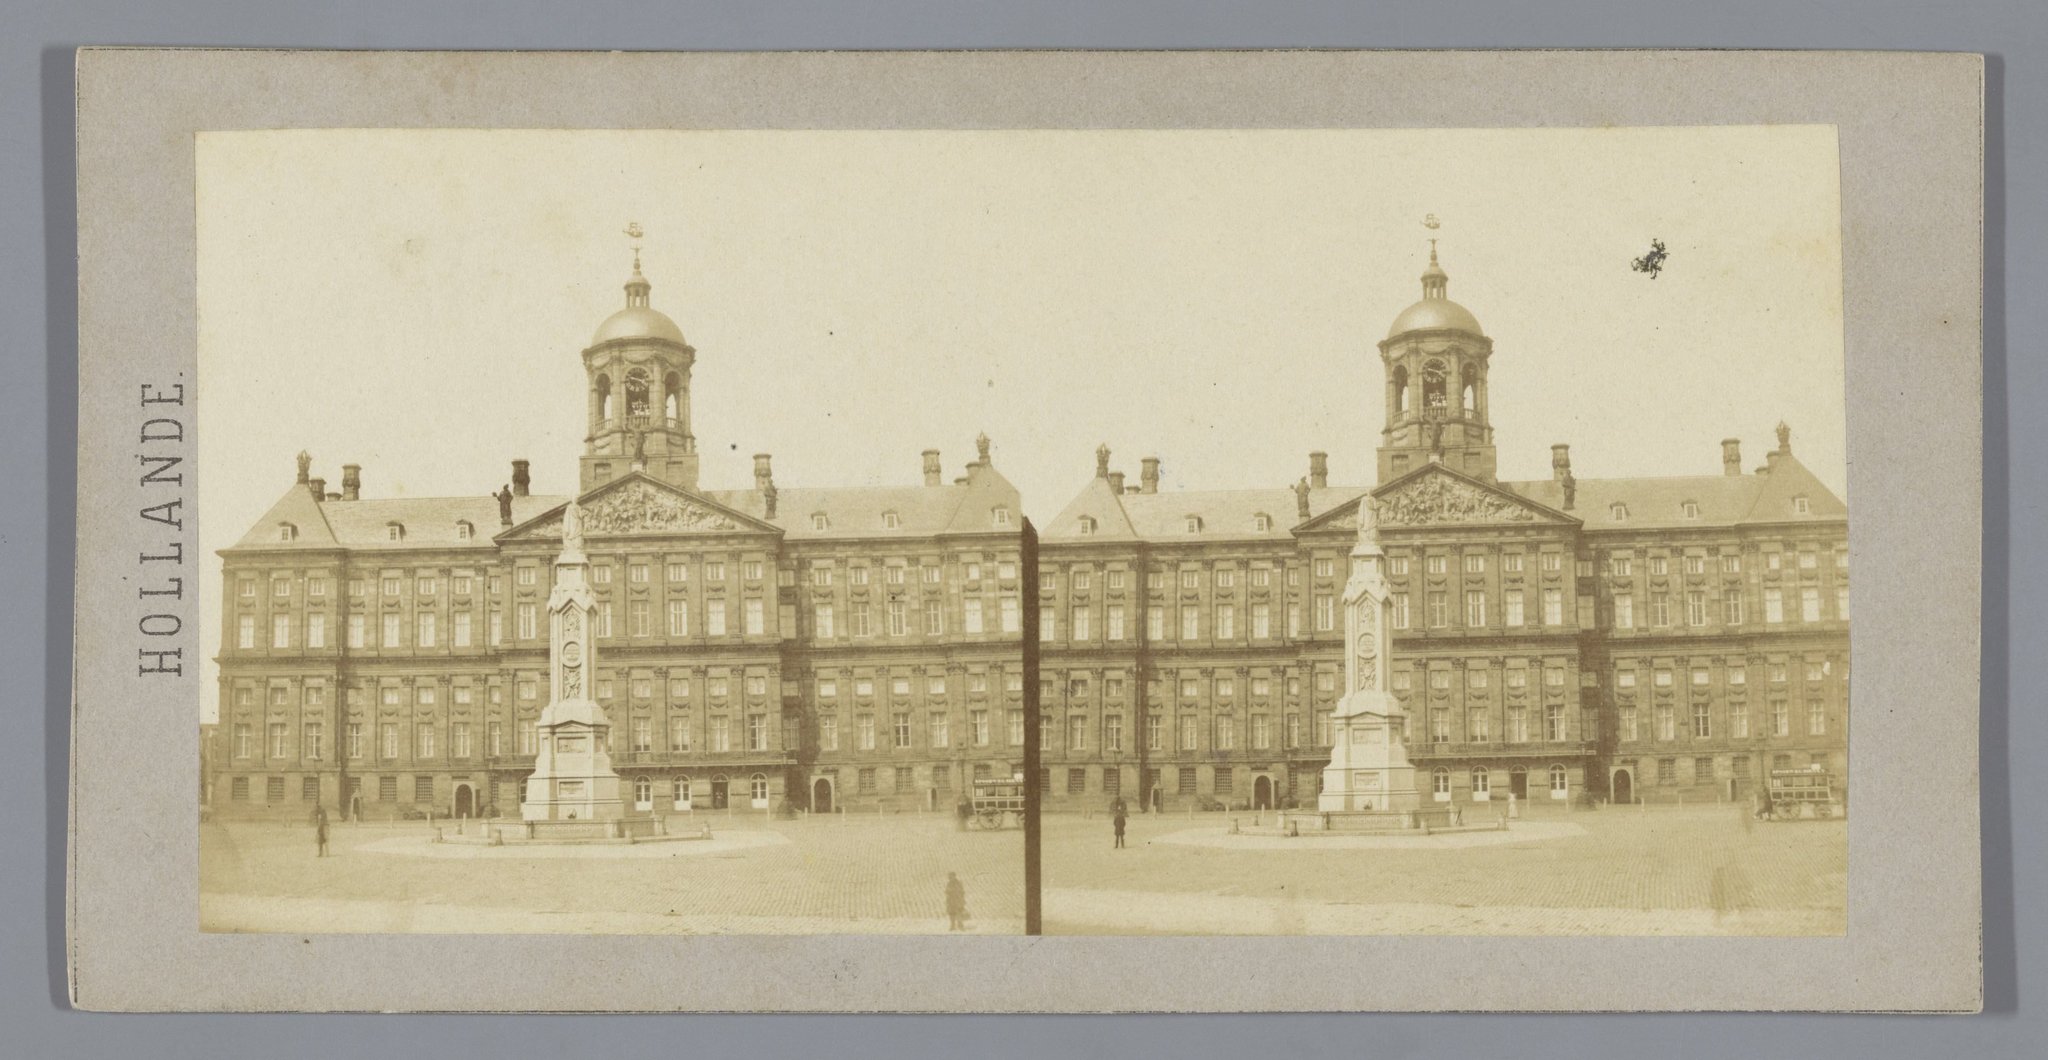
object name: stereograph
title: Palais du Roi sur le Dam a Amsterdam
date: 1858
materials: cardboard, paper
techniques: albumen print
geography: amsterdam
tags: square, place, circus, etc., palace, royal palace of amsterdam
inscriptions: number: ‘N. 1.’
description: Het Koninklijk Paleis met daarvoor het Monument ter herinnering aan den Volksgeest van 1830 en 1831 ('Naatje').